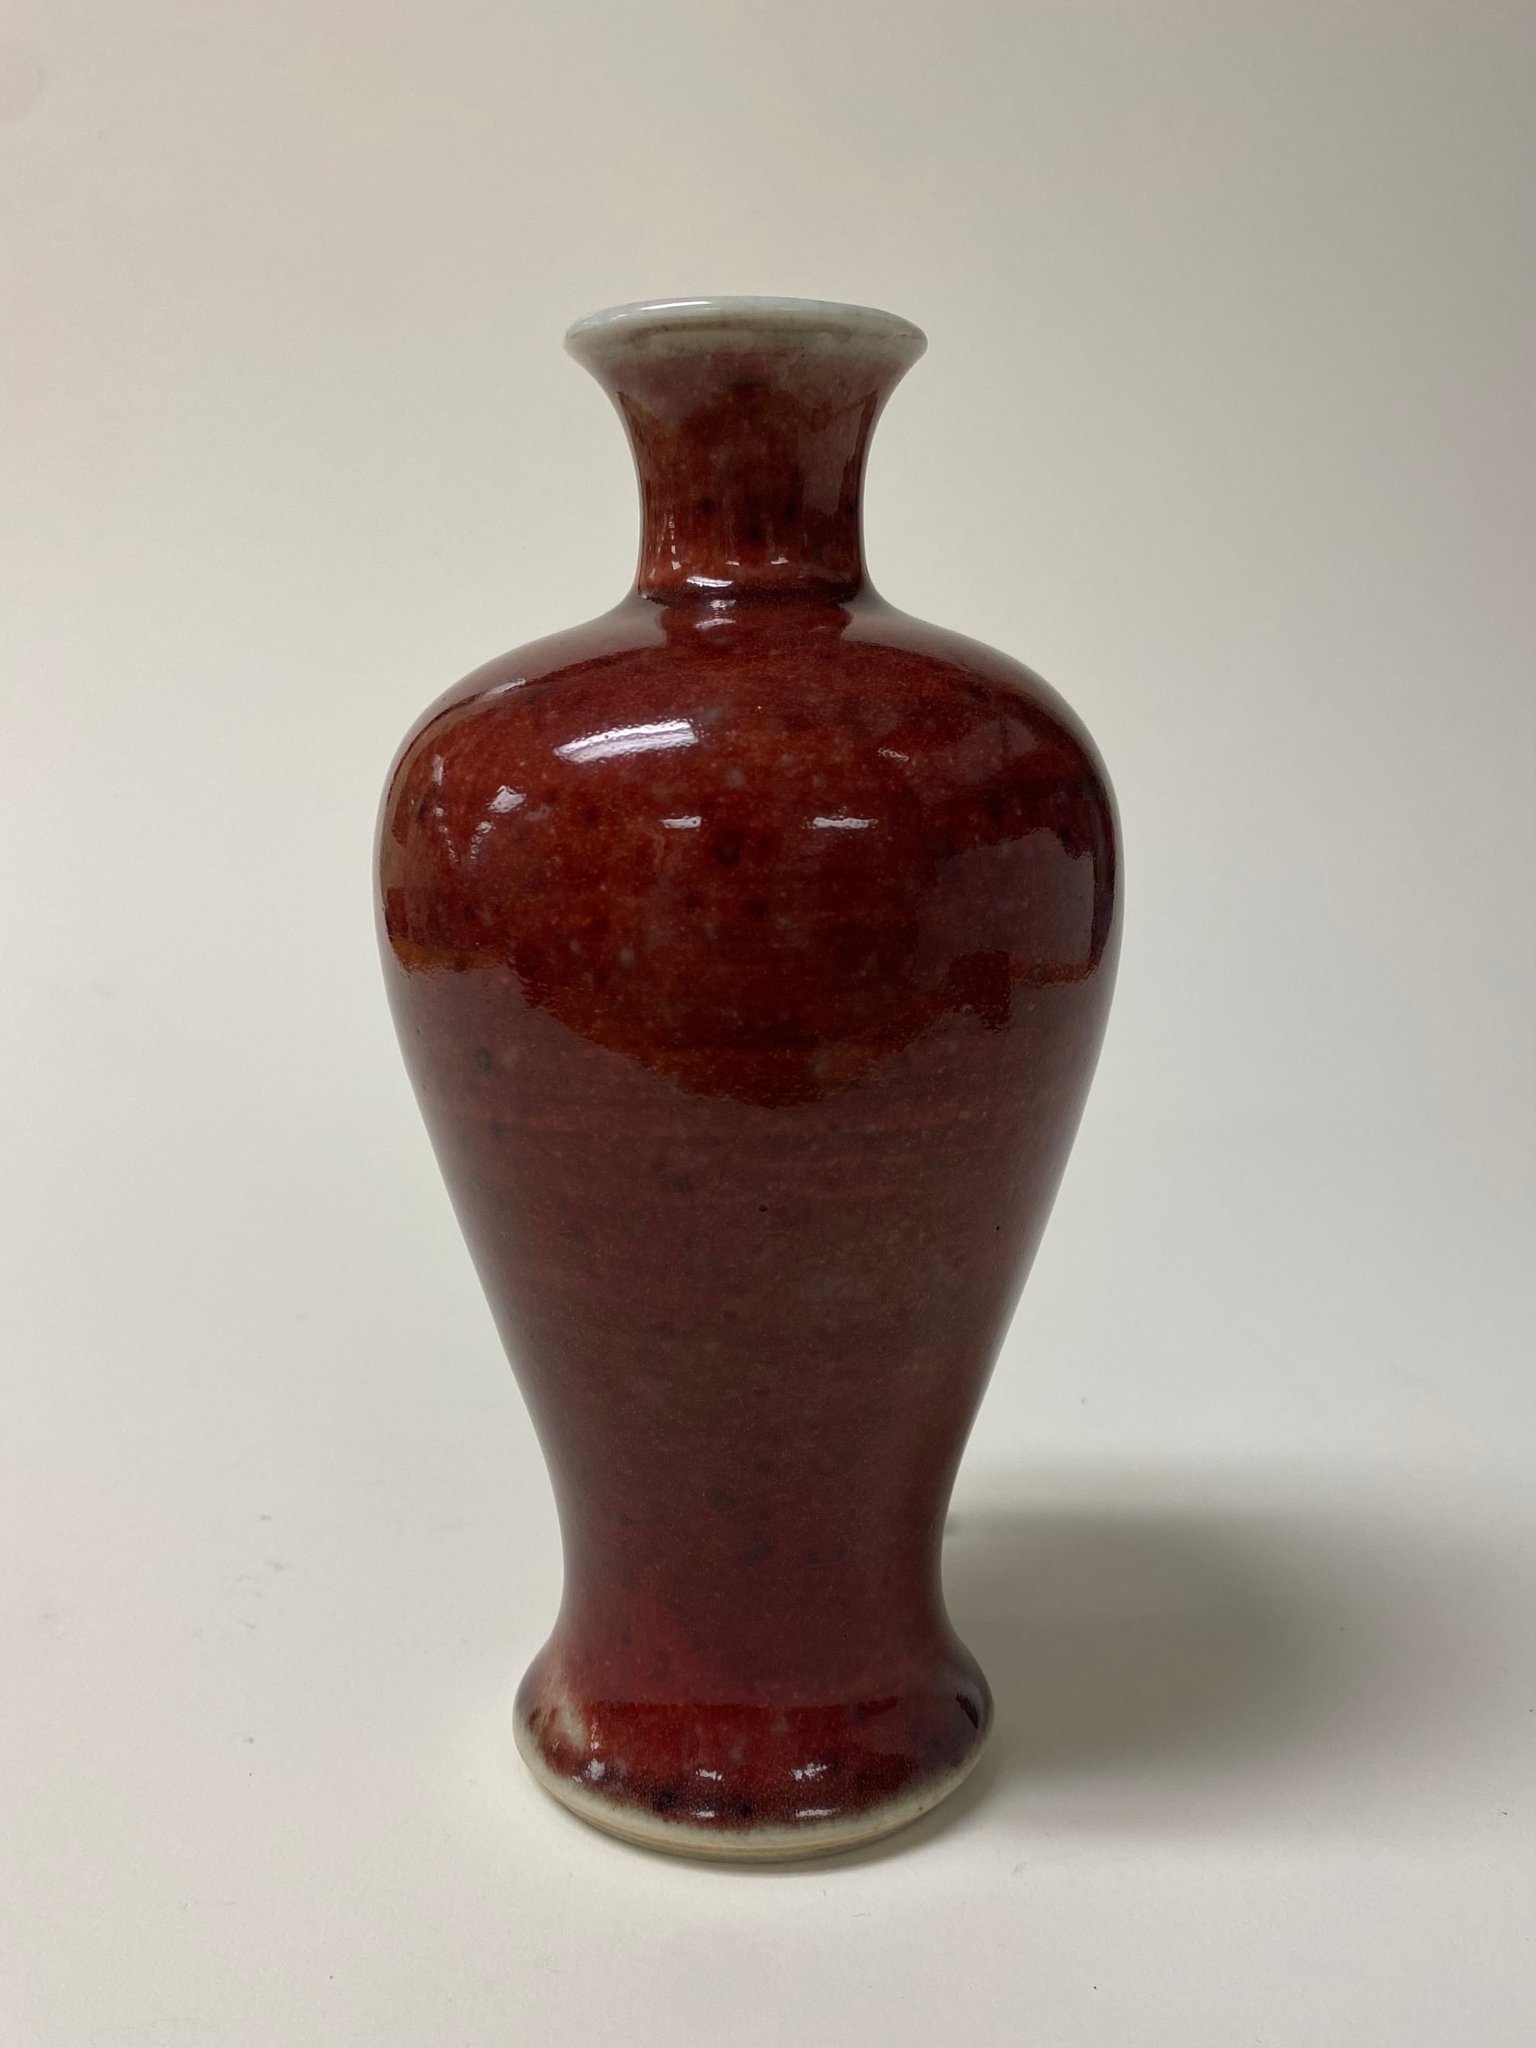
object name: vase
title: Meiping vase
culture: chinese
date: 1701-1800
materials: copper, glaze, porcelain